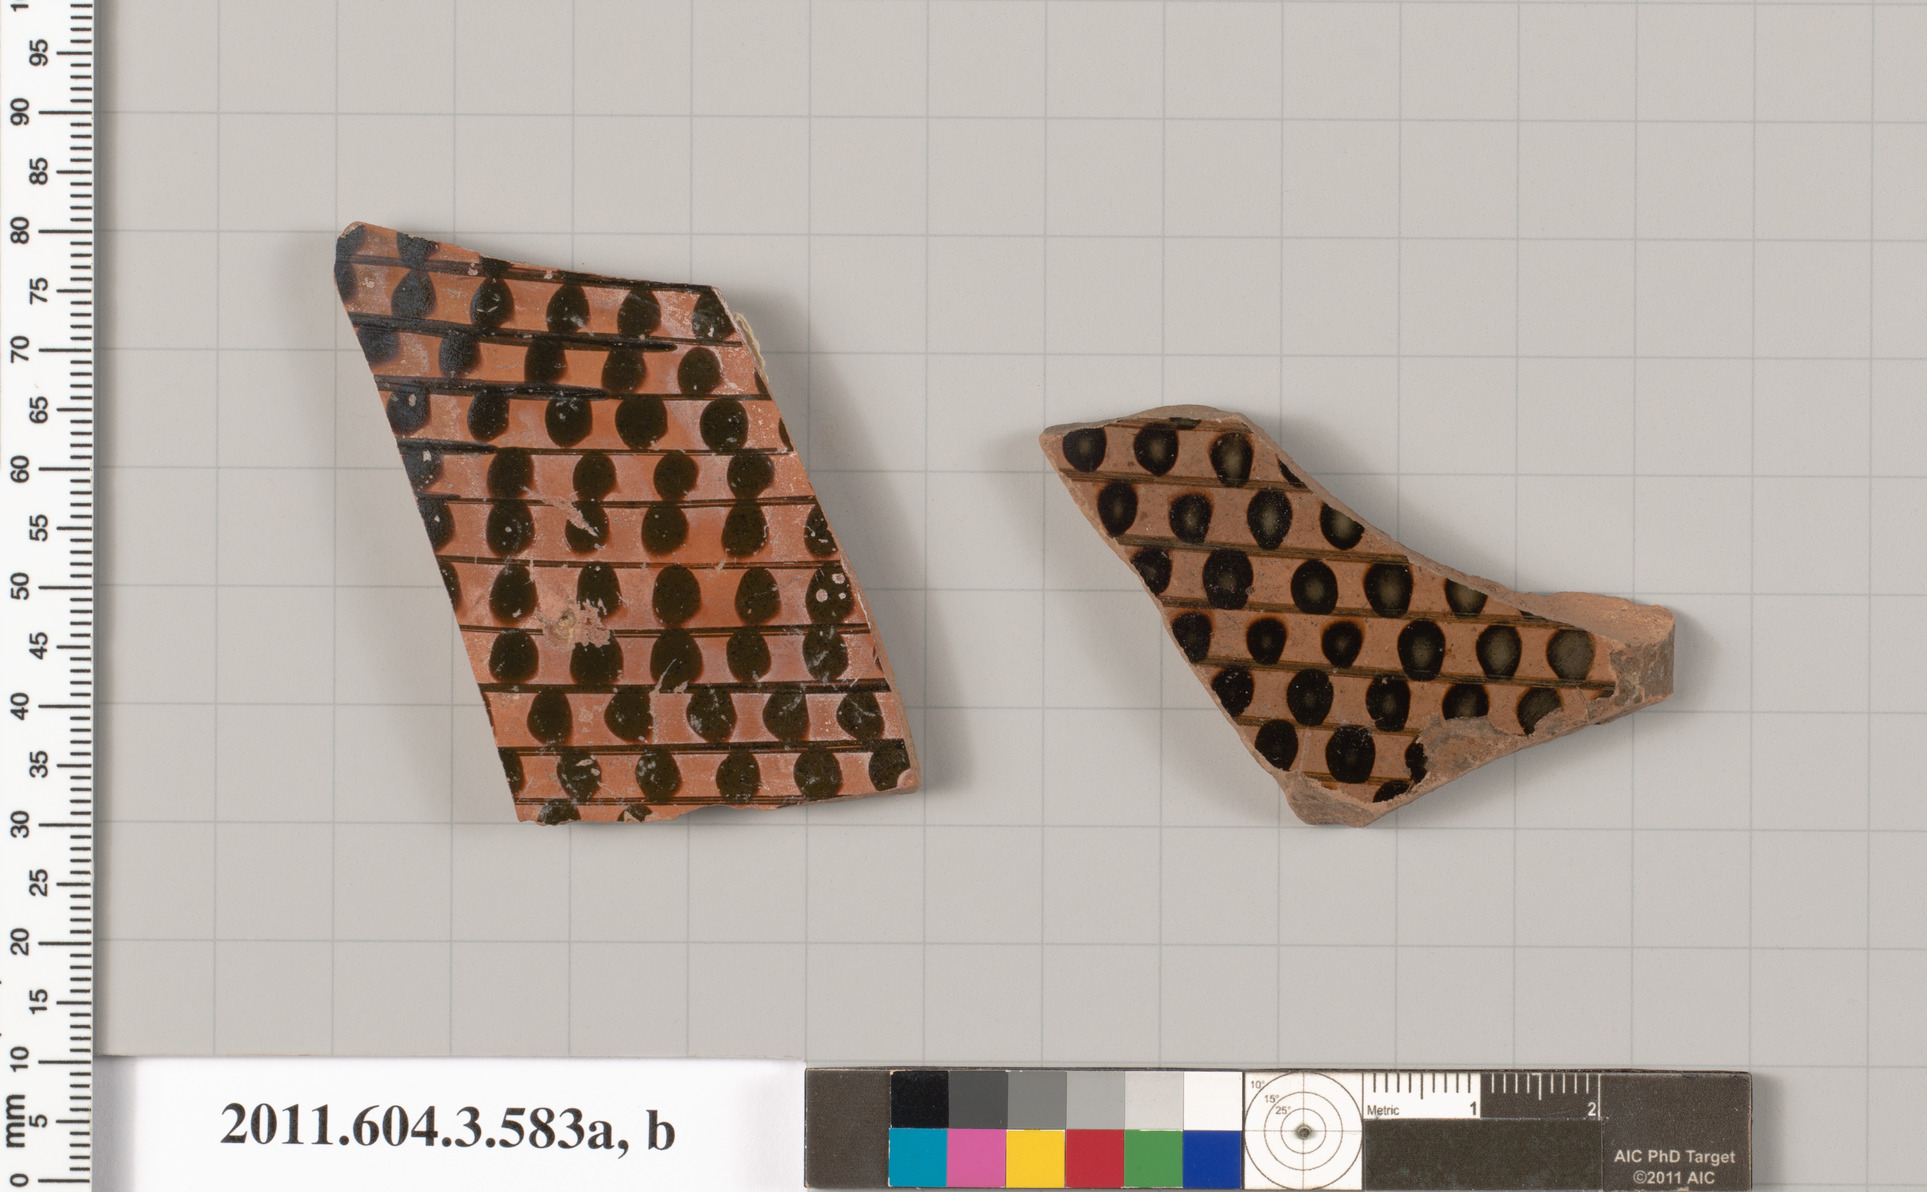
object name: column krater fragment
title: Terracotta fragments of column-kraters (bowls for mixing wine and water)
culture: greek, attic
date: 534-468 BCE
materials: terracotta